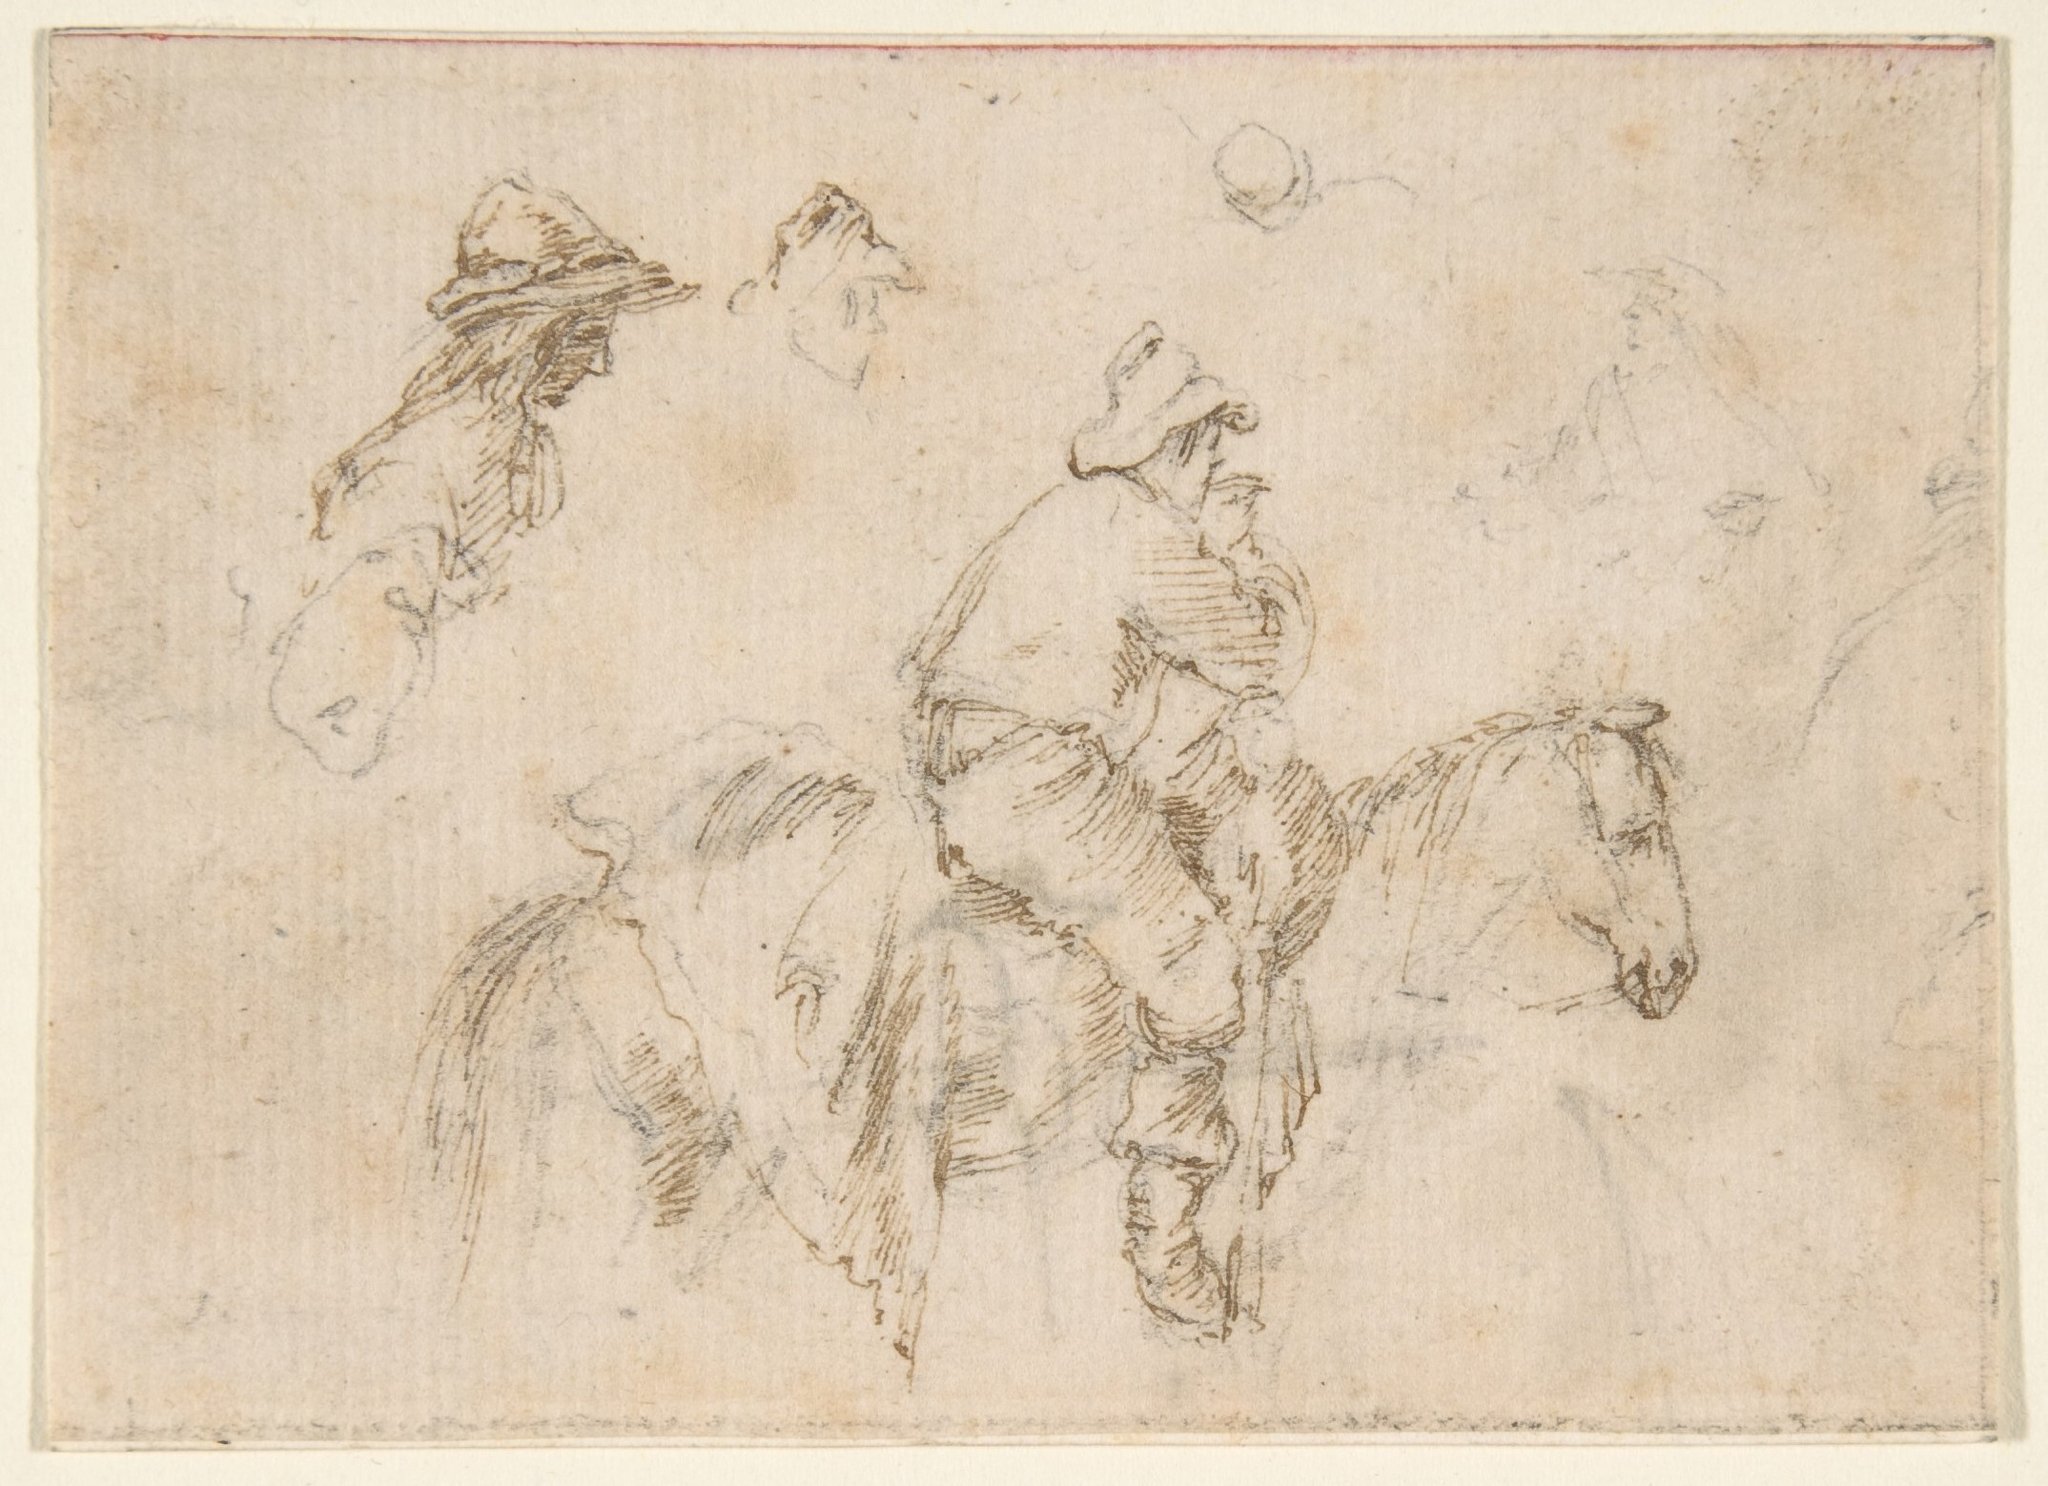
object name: drawing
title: A Peasant on Horseback seen in Profile Facing Right; Two Studies of the Same Man's Head.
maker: stefano della bella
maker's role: artist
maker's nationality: italian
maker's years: 1610-1664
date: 1610-1664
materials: graphite, ink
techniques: pen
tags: heads,profiles,horses